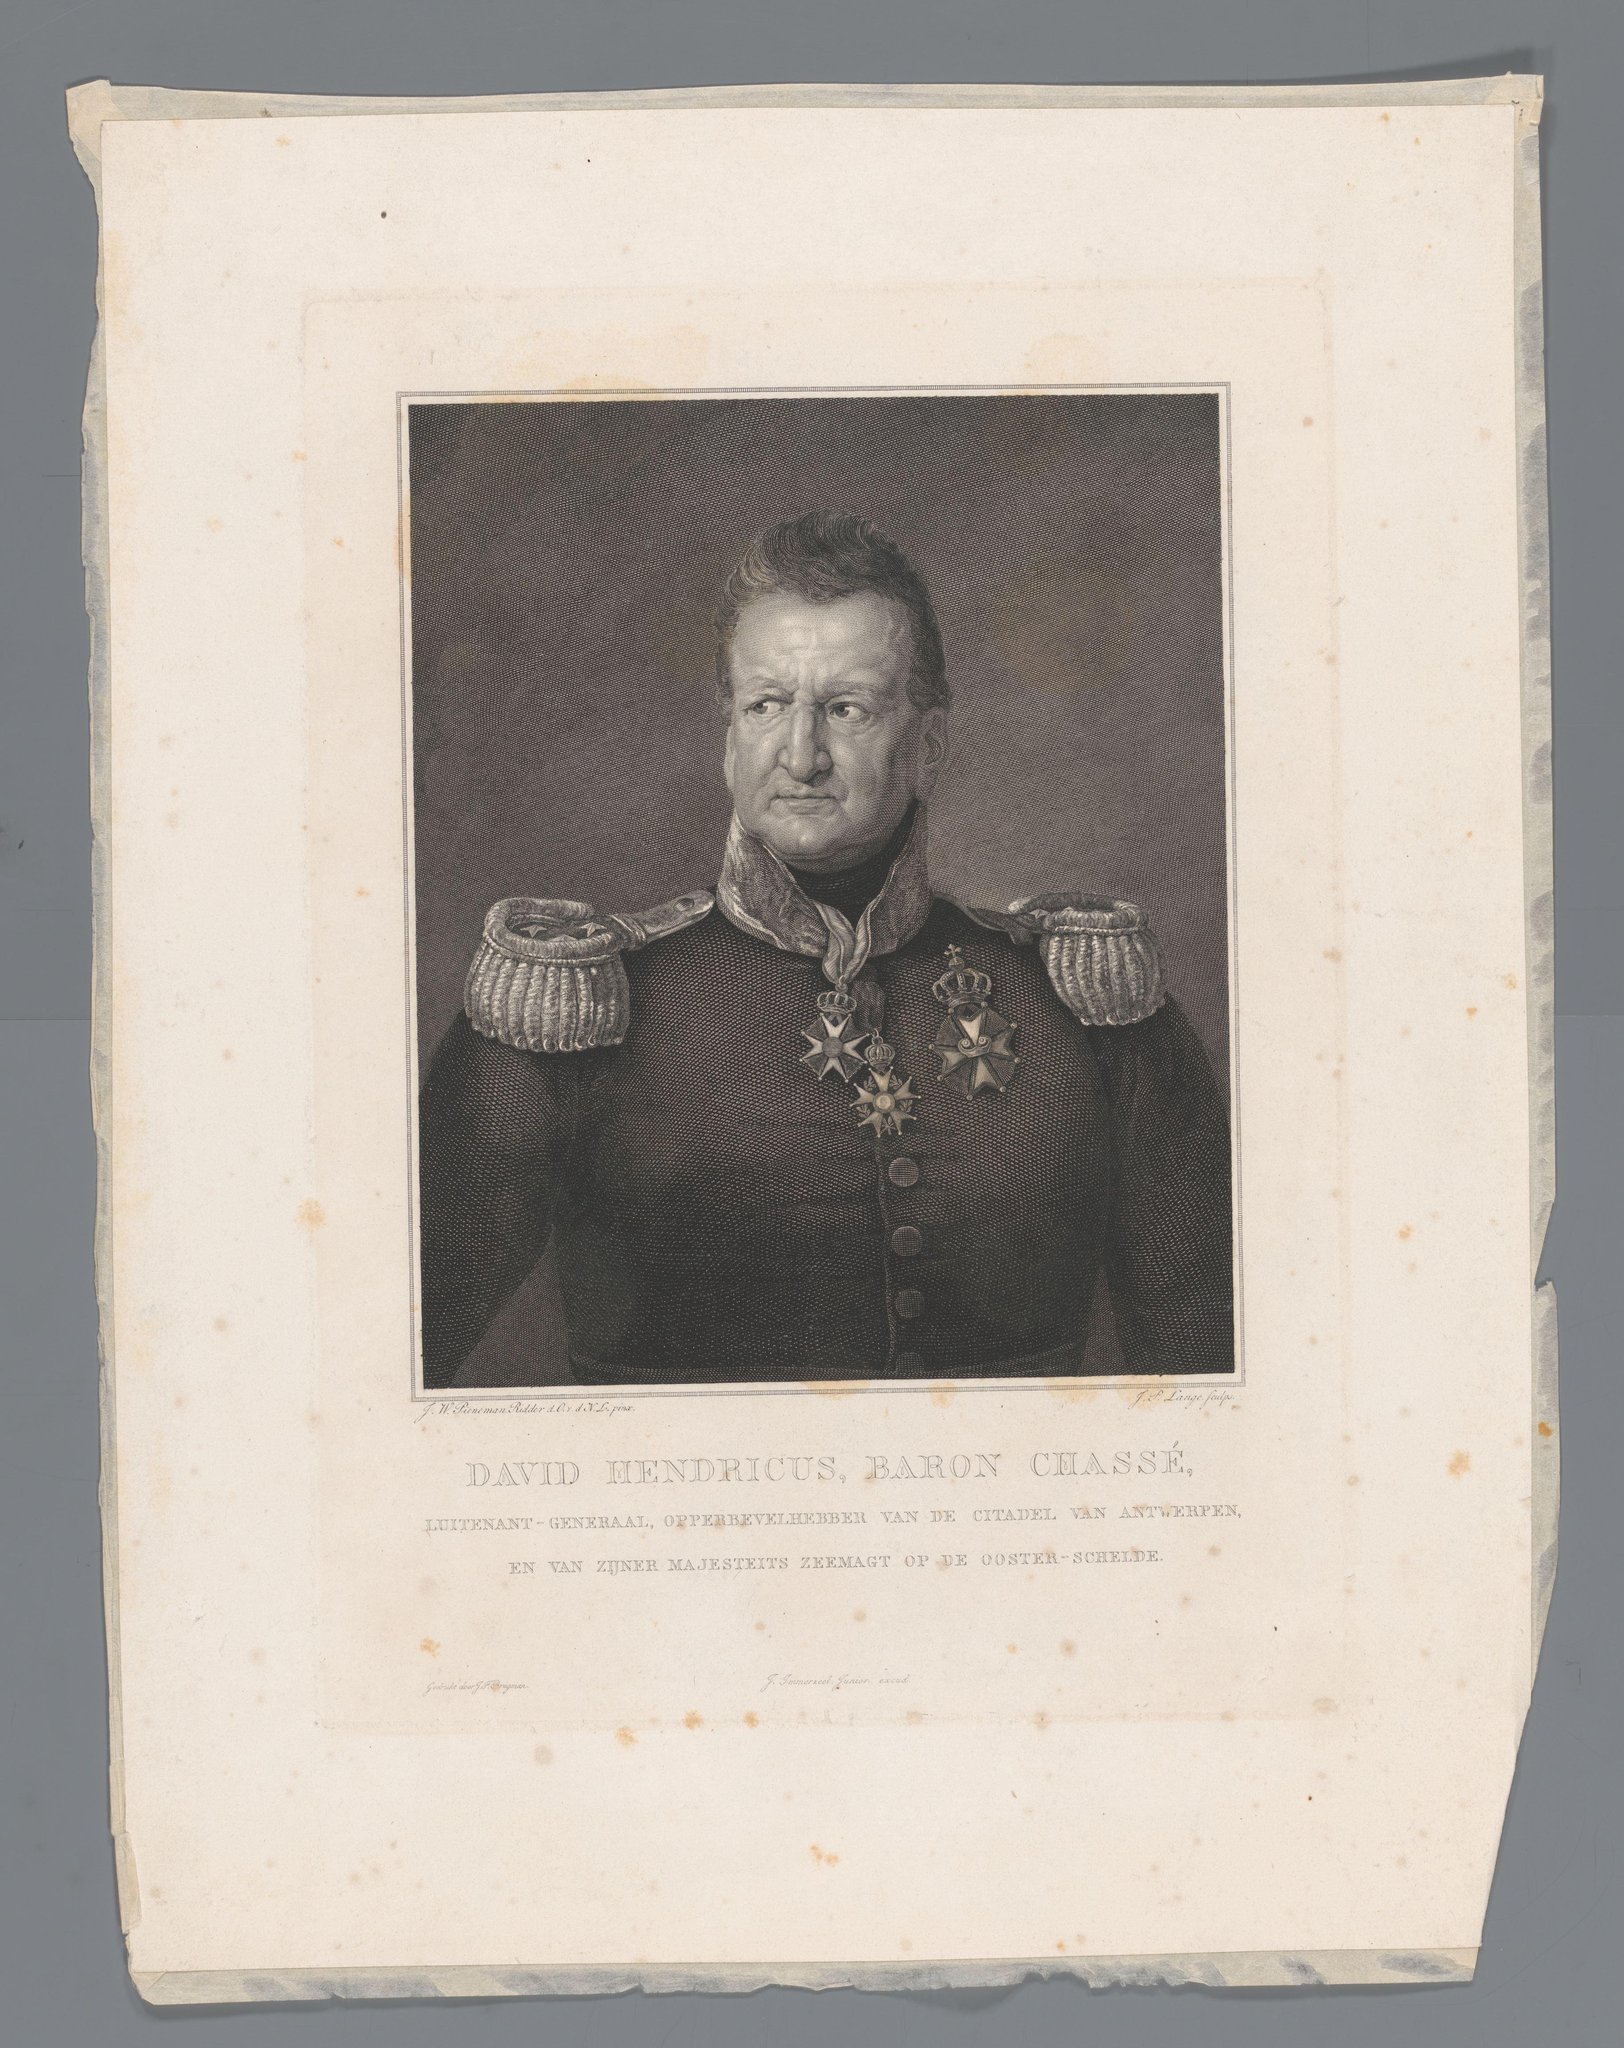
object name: print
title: David Hendricus, baron Chassé, Luitenant-Generaal, opperbevelhebber van de Citadel van Antwerpen, en van Zijner Majesteits zeemagt op de Ooster-Schelde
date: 1831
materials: paper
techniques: engraving, etching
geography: amsterdam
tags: david hendrik baron chassé, historical persons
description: Portret van baron Chassé, borststuk, hoofd naar links, met epauletten en drie ridderordes.